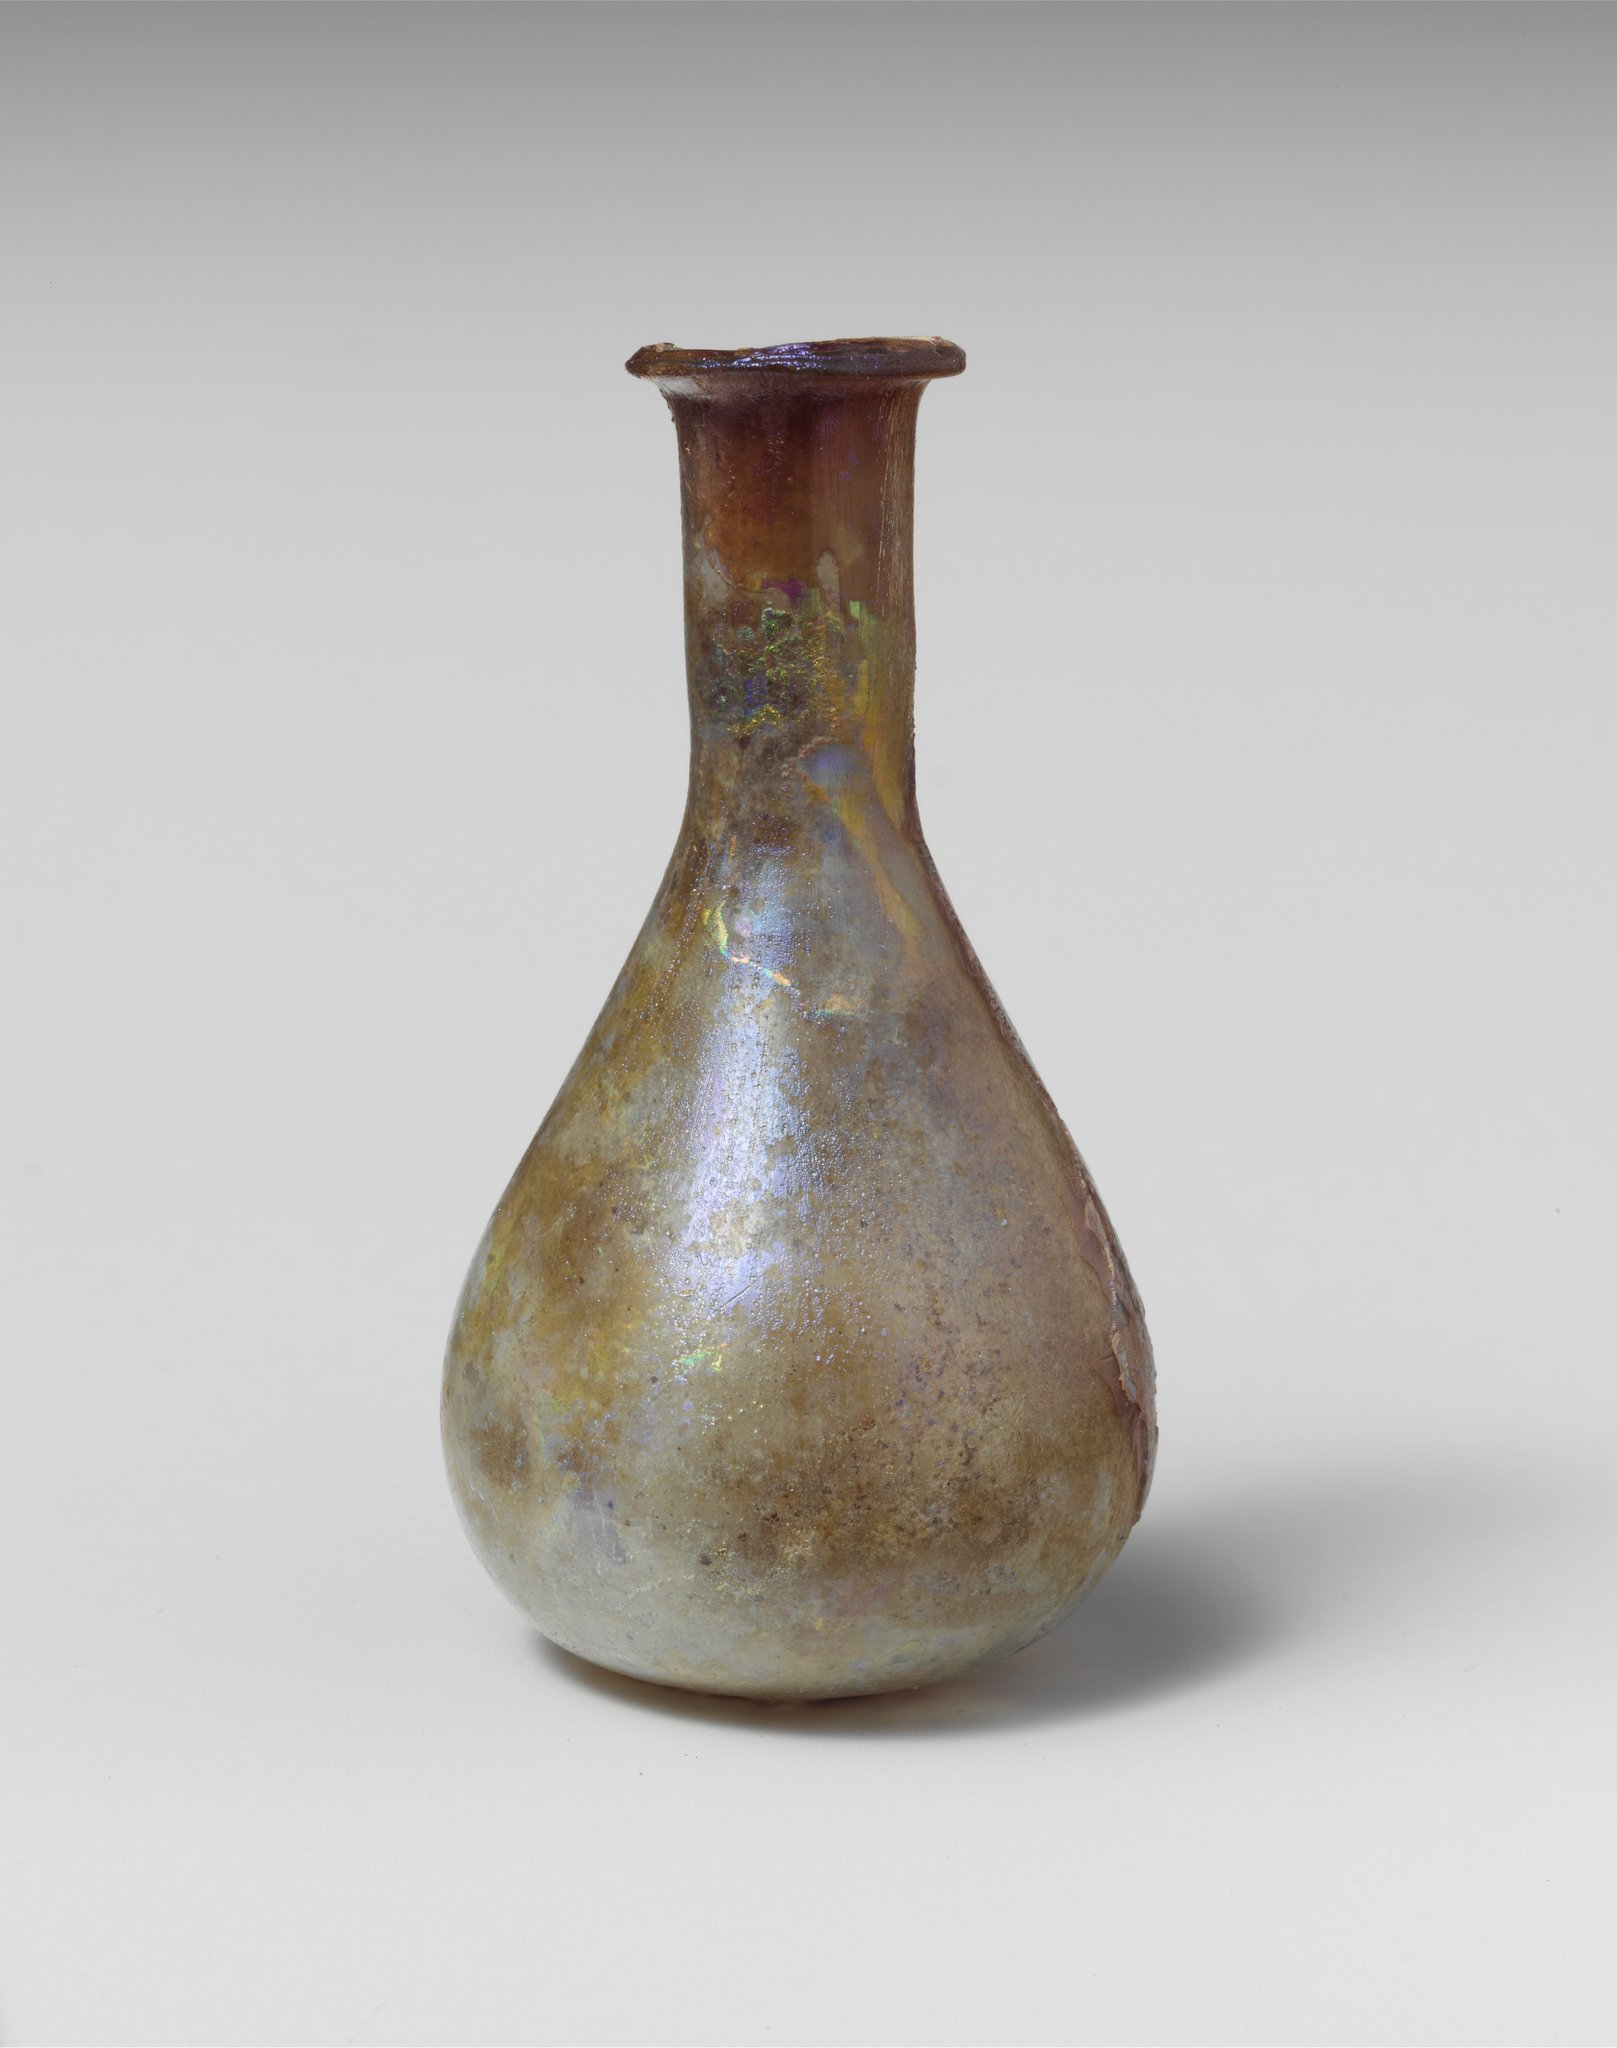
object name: perfume bottle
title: Glass perfume bottle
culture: roman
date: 1-100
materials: glass